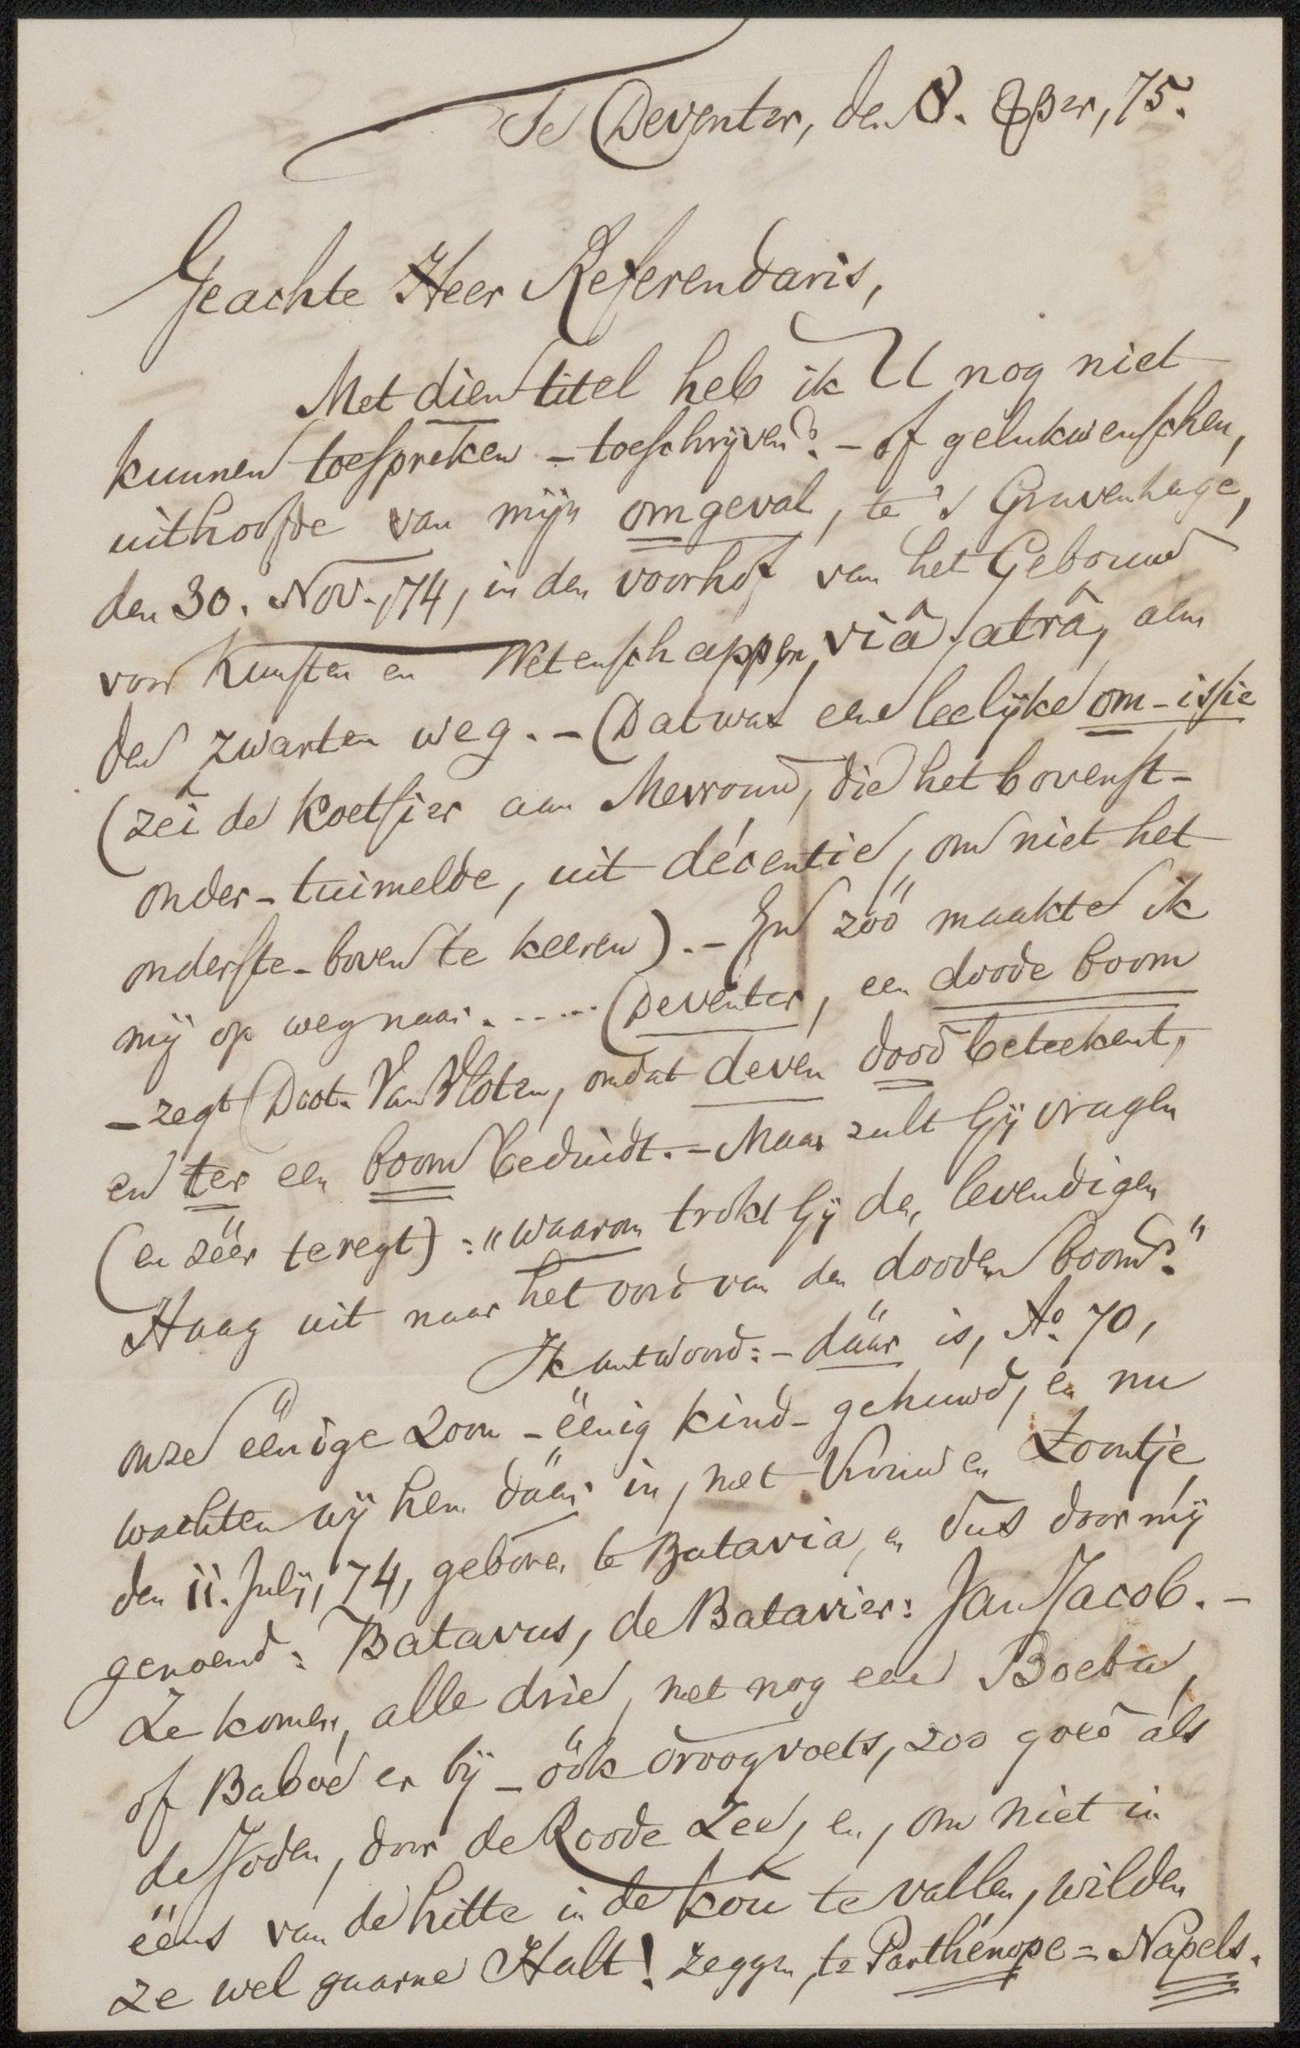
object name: letter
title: Brief aan Philip Zilcken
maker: johannes jacobus franciscus wap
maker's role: letterkundige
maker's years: 1806-1880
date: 1875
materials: ink, paper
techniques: pen, writing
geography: deventer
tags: the hague, painter, draughtsman, philip zilcken, family life, deventer, naples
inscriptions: collector's mark: ‘RPK’